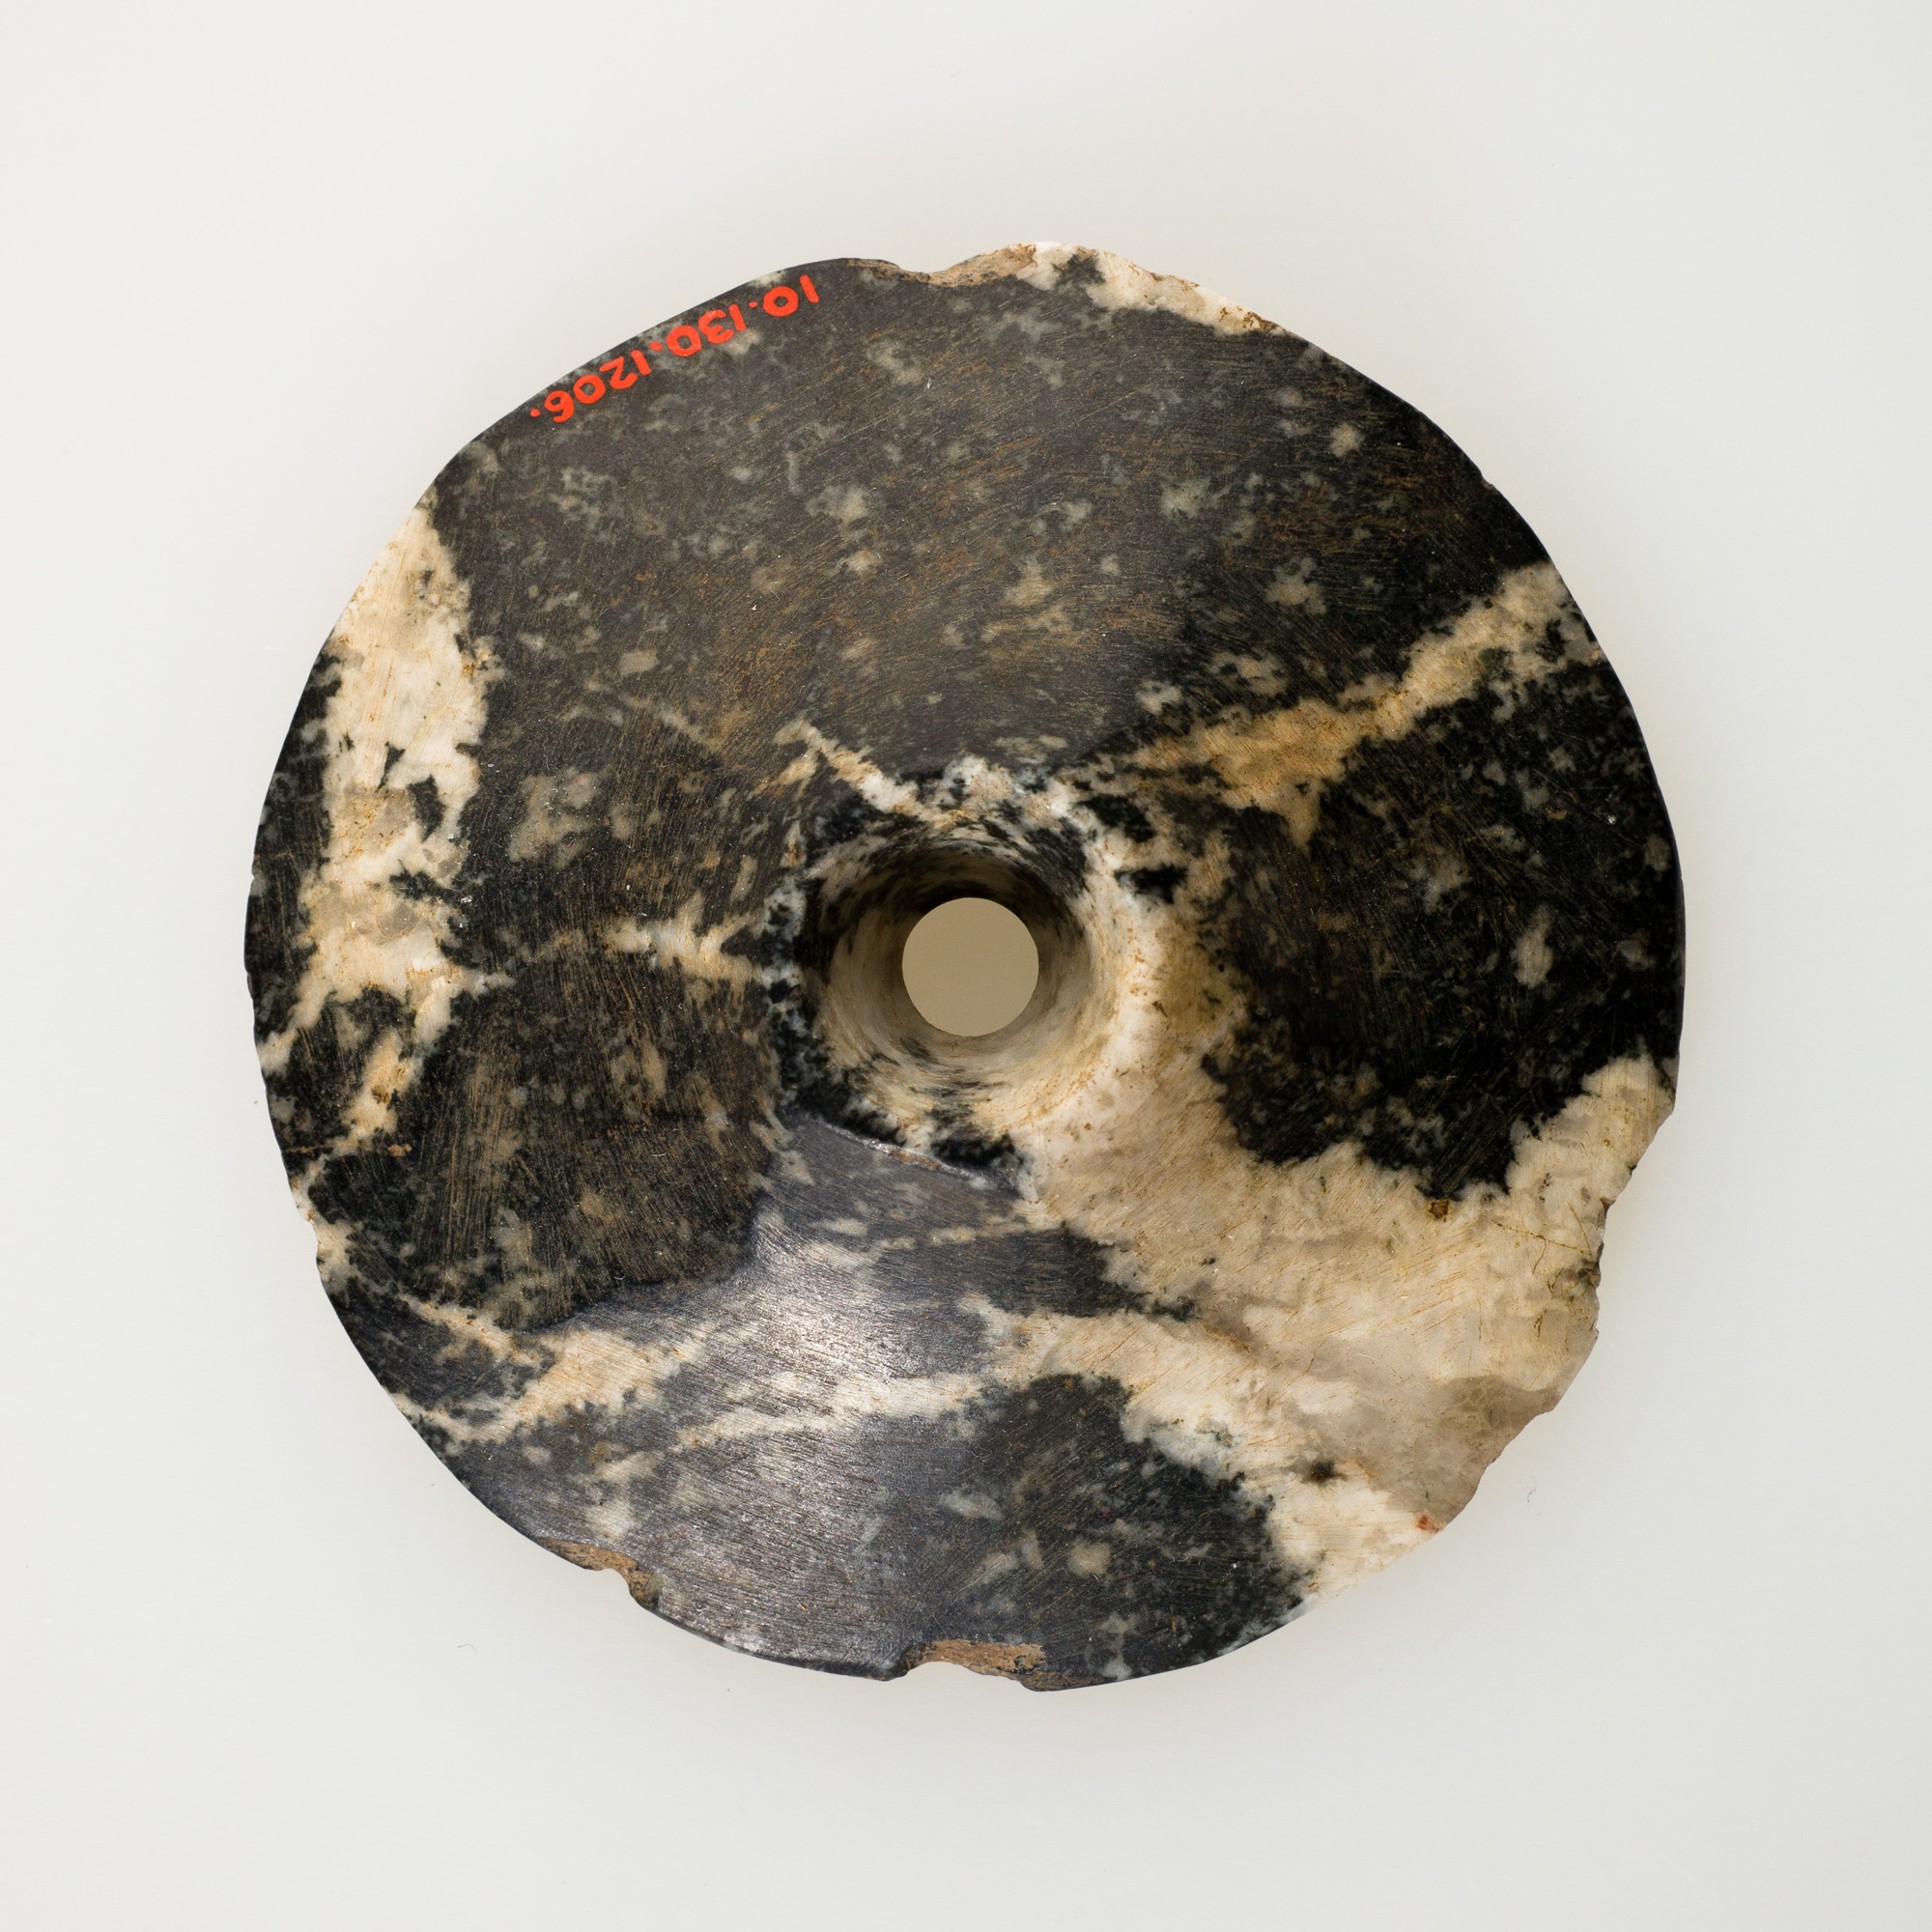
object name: mace head, disc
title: Disc-shaped mace head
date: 3850-2960 BCE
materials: stone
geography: egypt